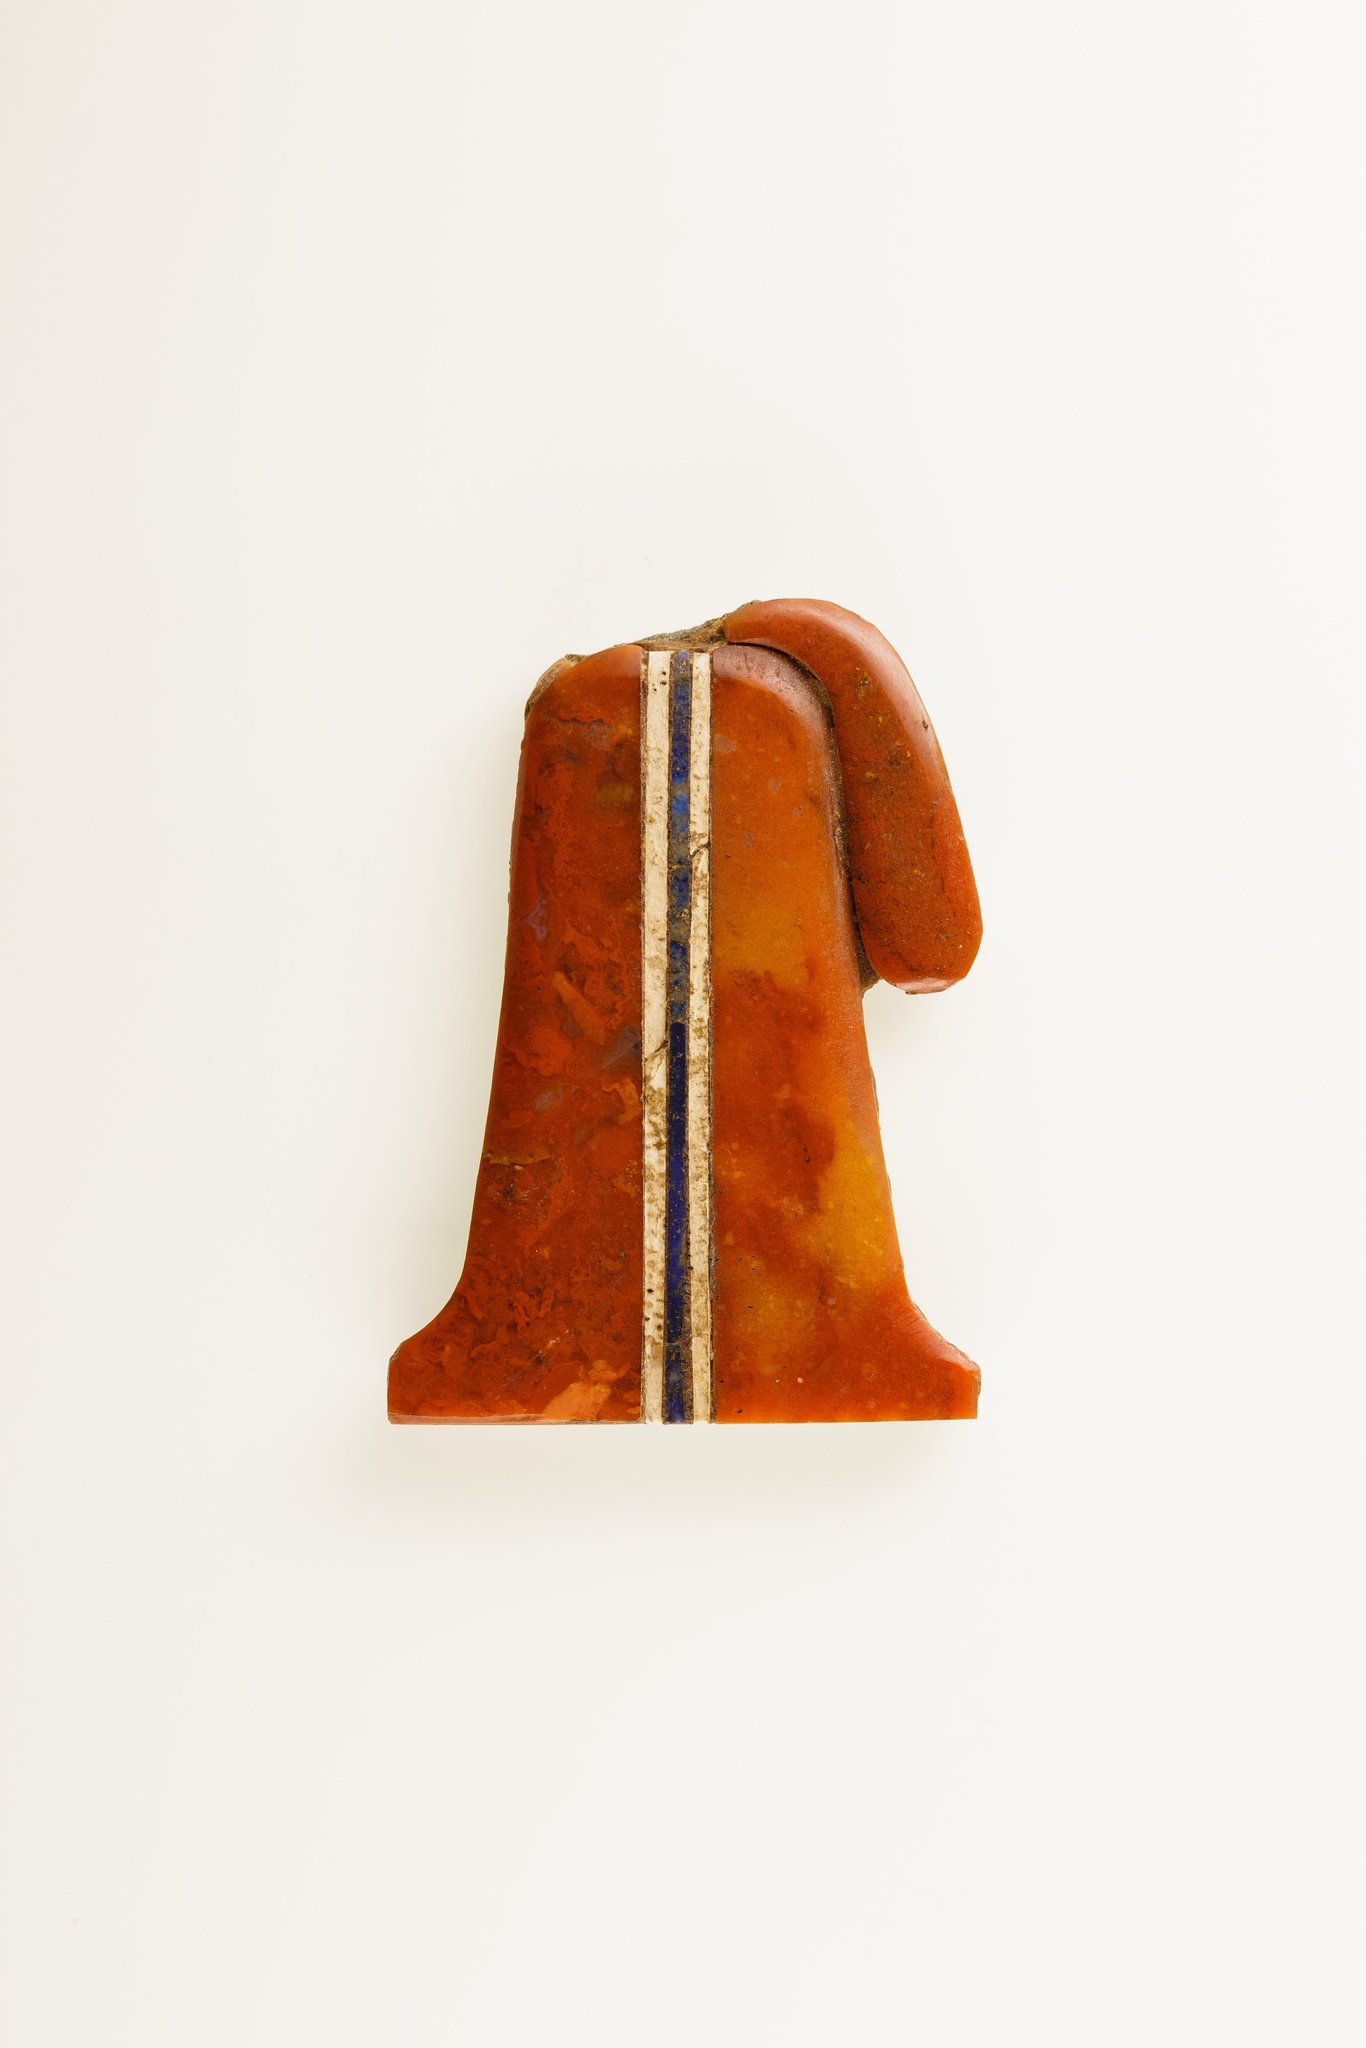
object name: inlay, hieroglyph, tit, buckle tie sign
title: Tit sign inlay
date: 1070-525 BCE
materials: jasper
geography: egypt